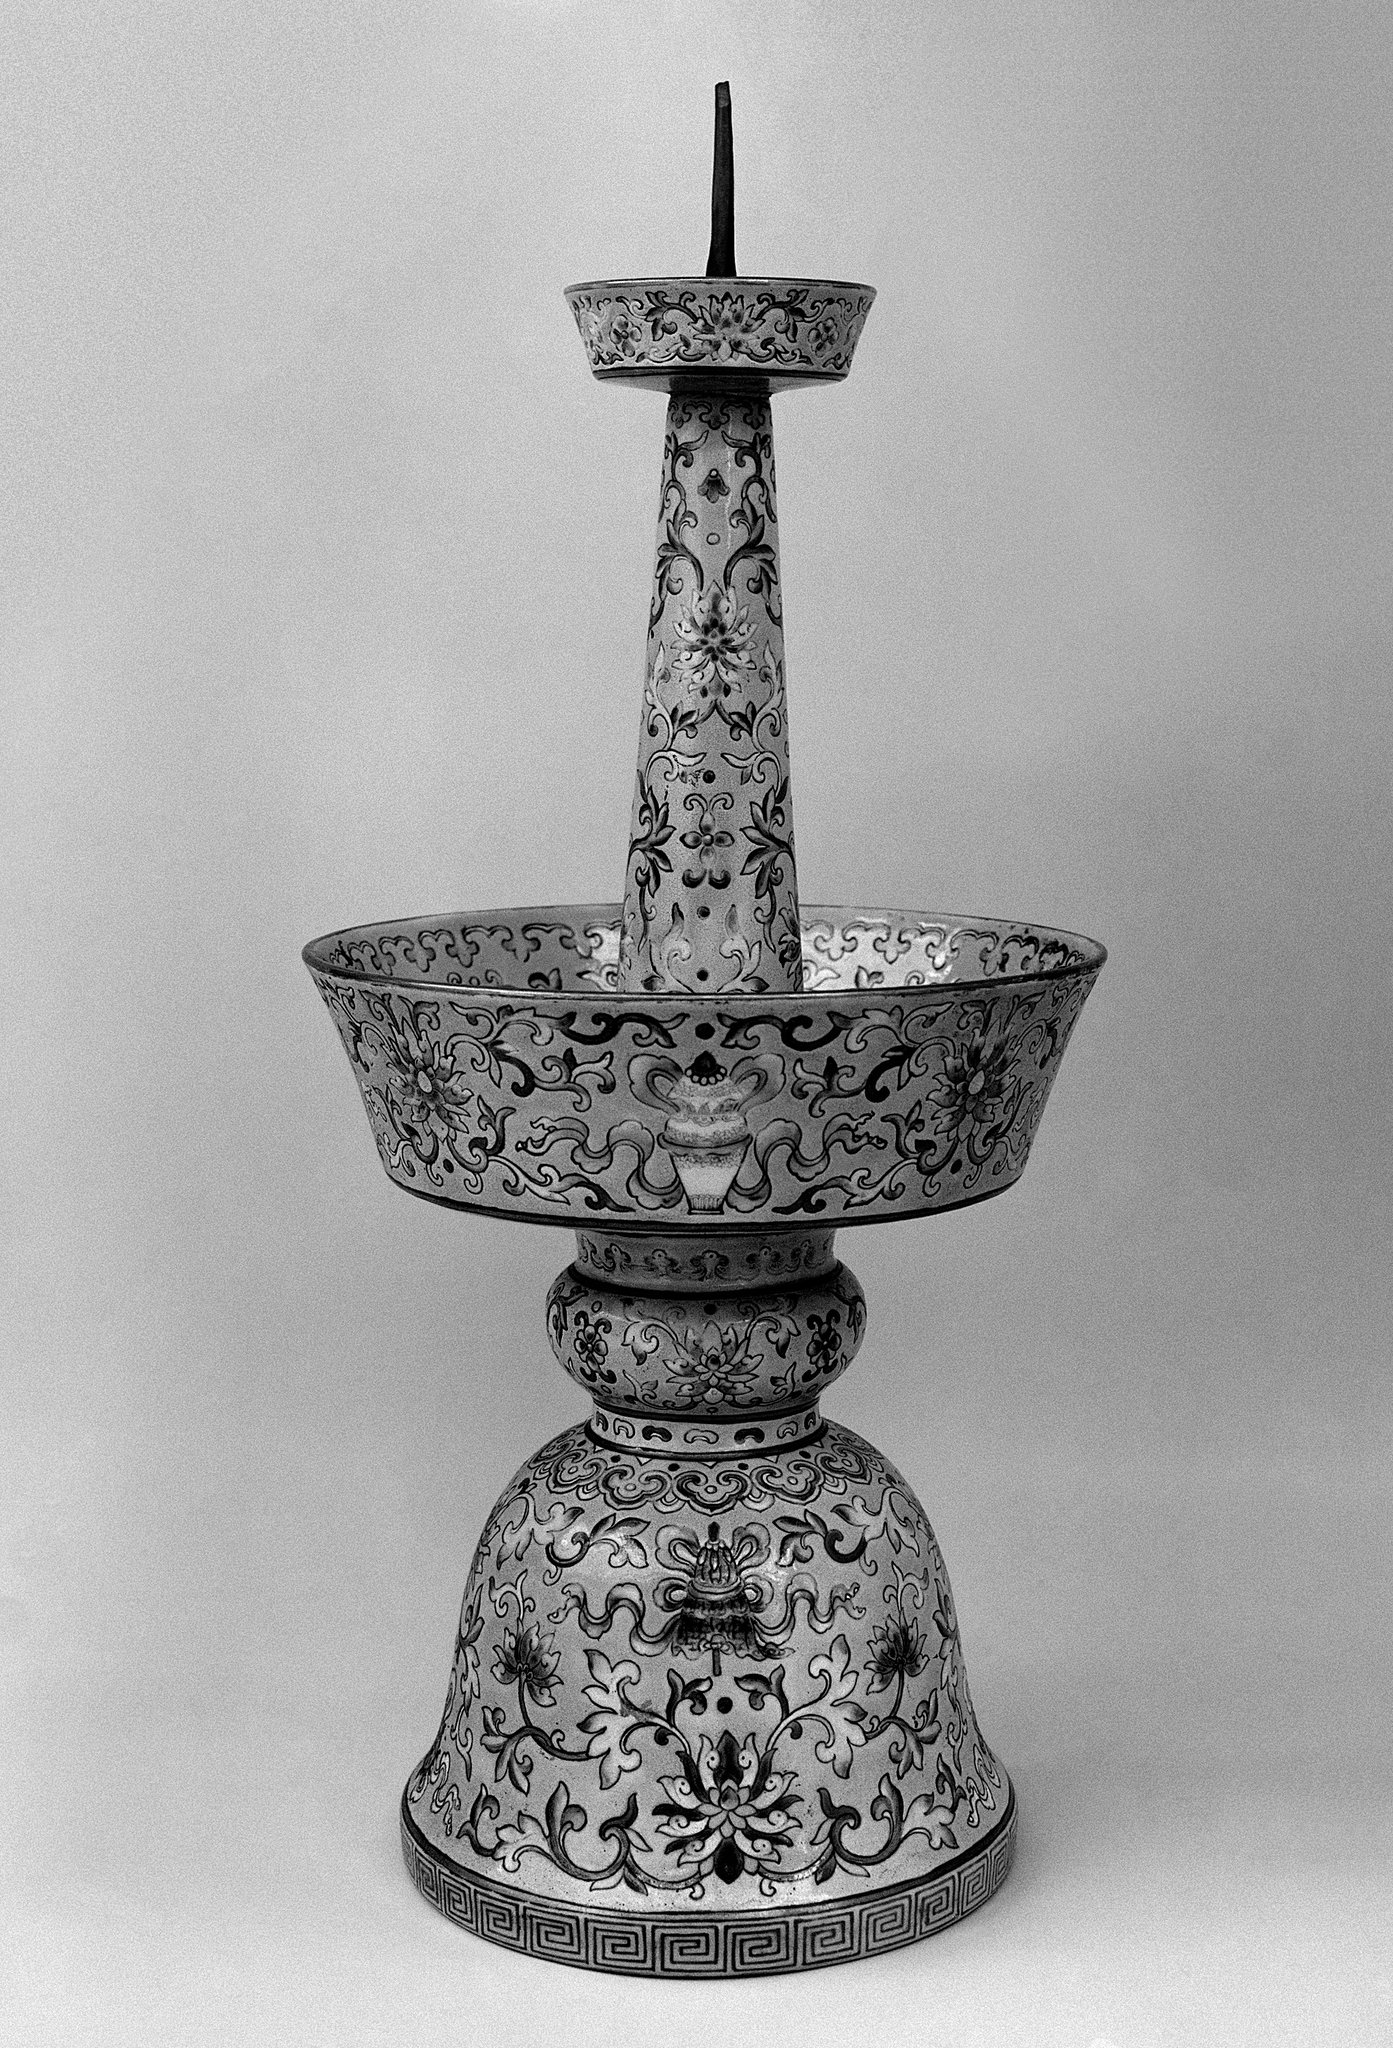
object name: altar set piece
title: Candlestick from a Set Five-Piece Altar Set (Wugong)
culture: chinese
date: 1821-1850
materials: porcelain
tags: flowers